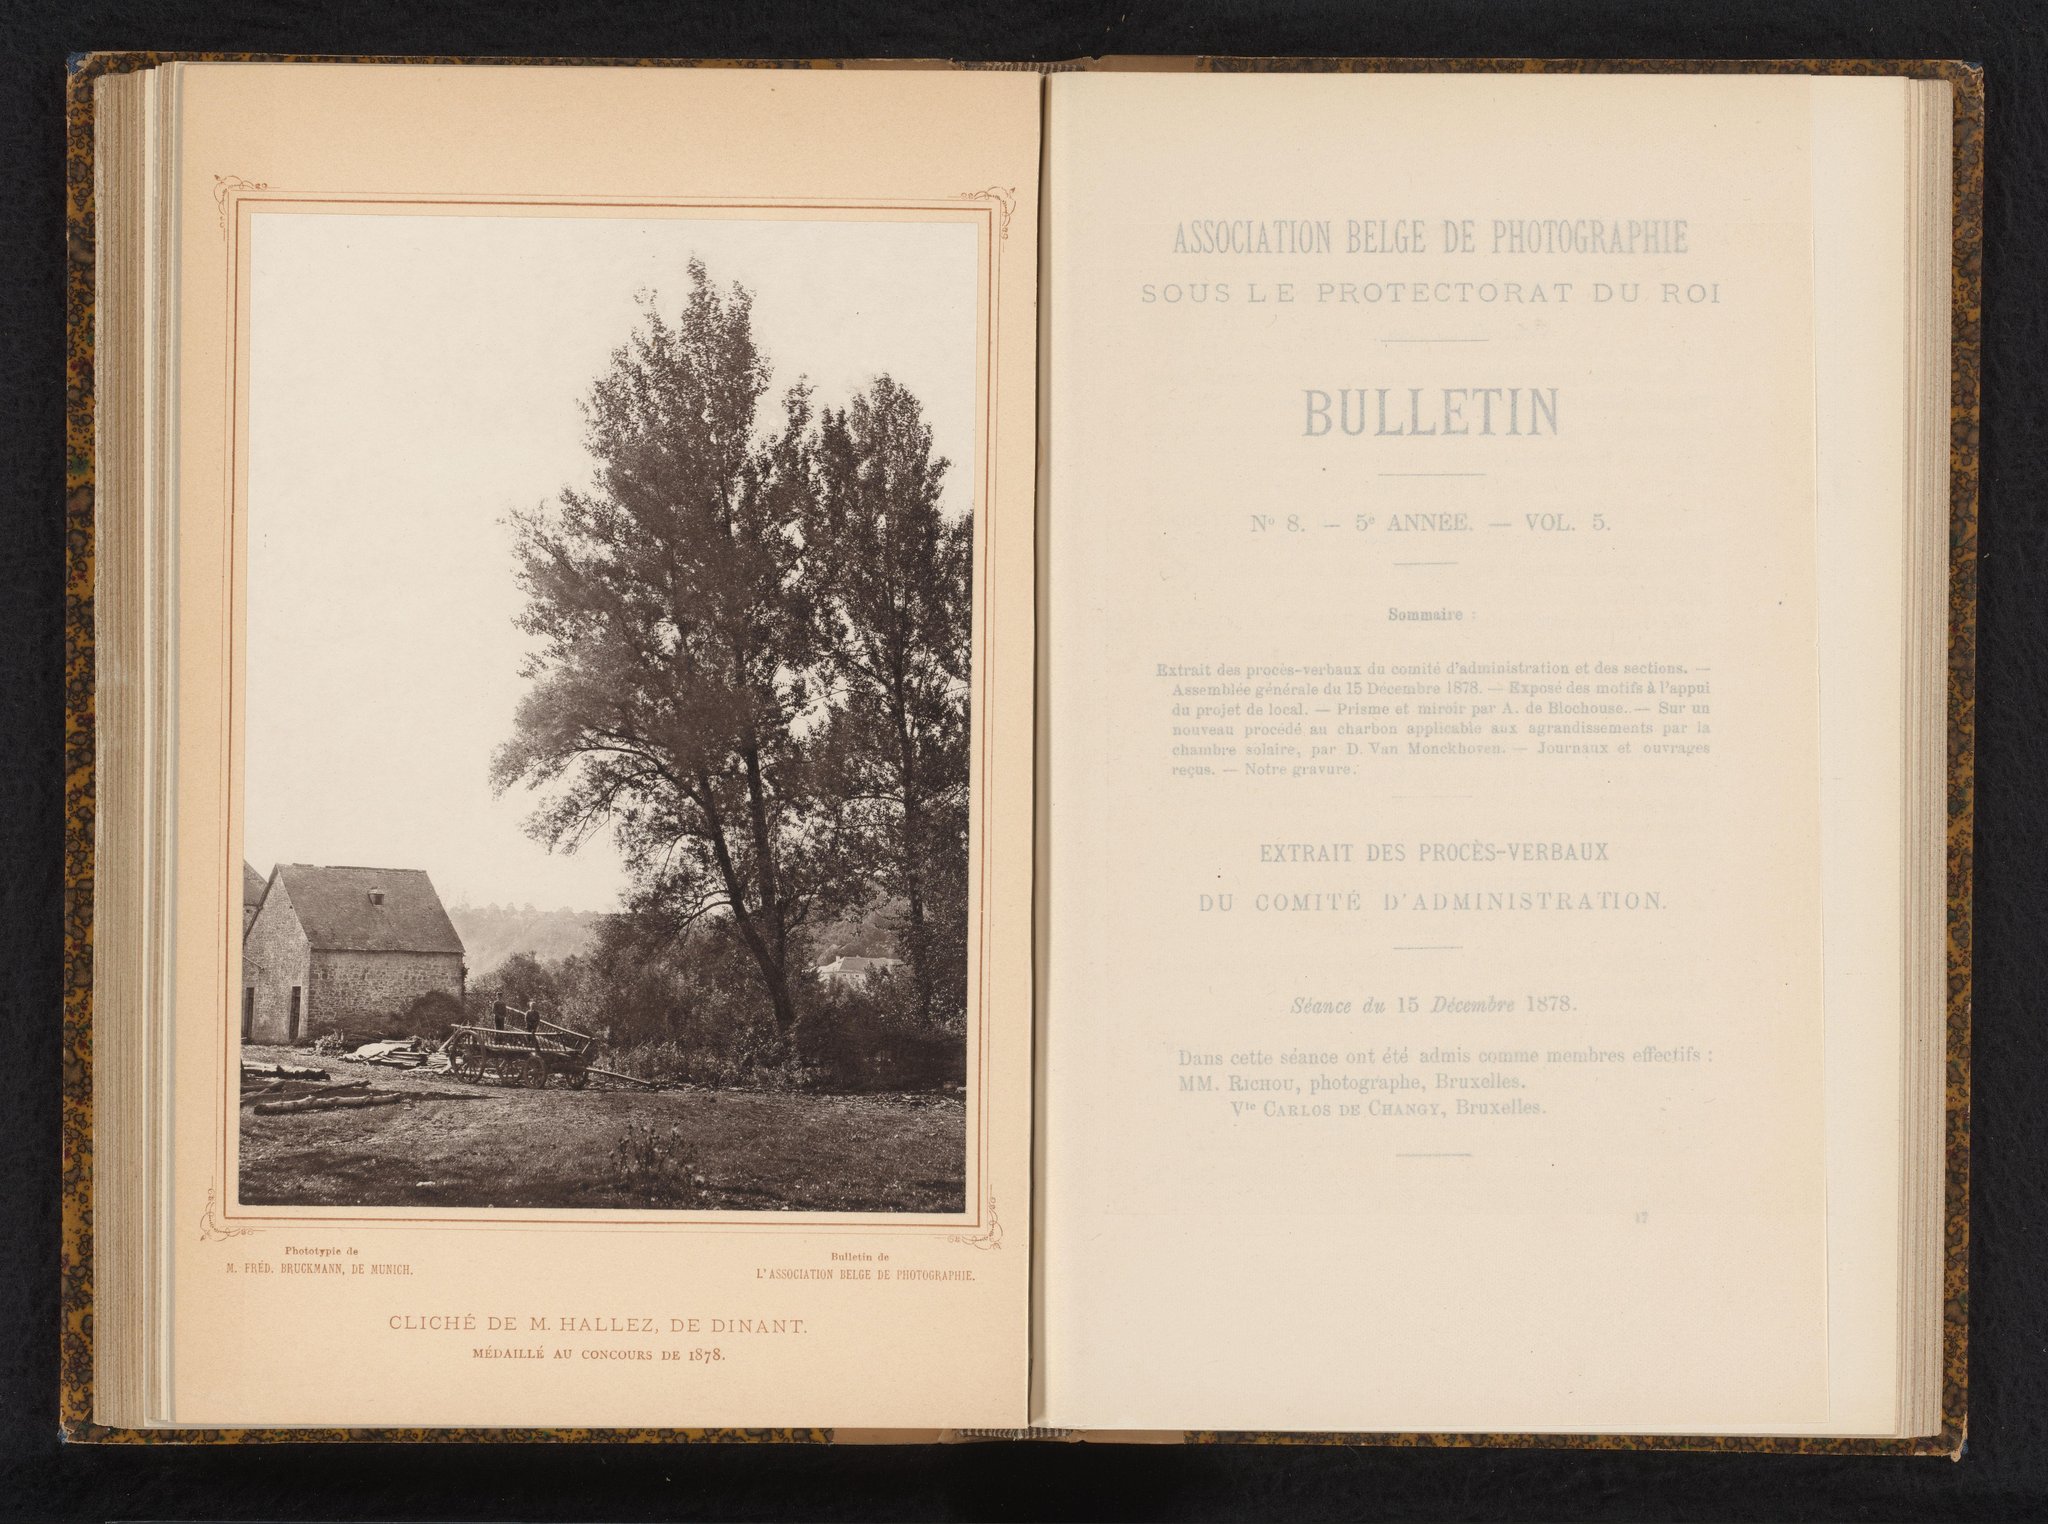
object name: photomechanical print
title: Portret van William de Wiveleslie Abney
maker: william mayland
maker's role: fotograaf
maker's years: 1821-1907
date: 1878-1879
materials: paper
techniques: woodburytype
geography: london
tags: william de wiveleslie abney, adult man, historical persons